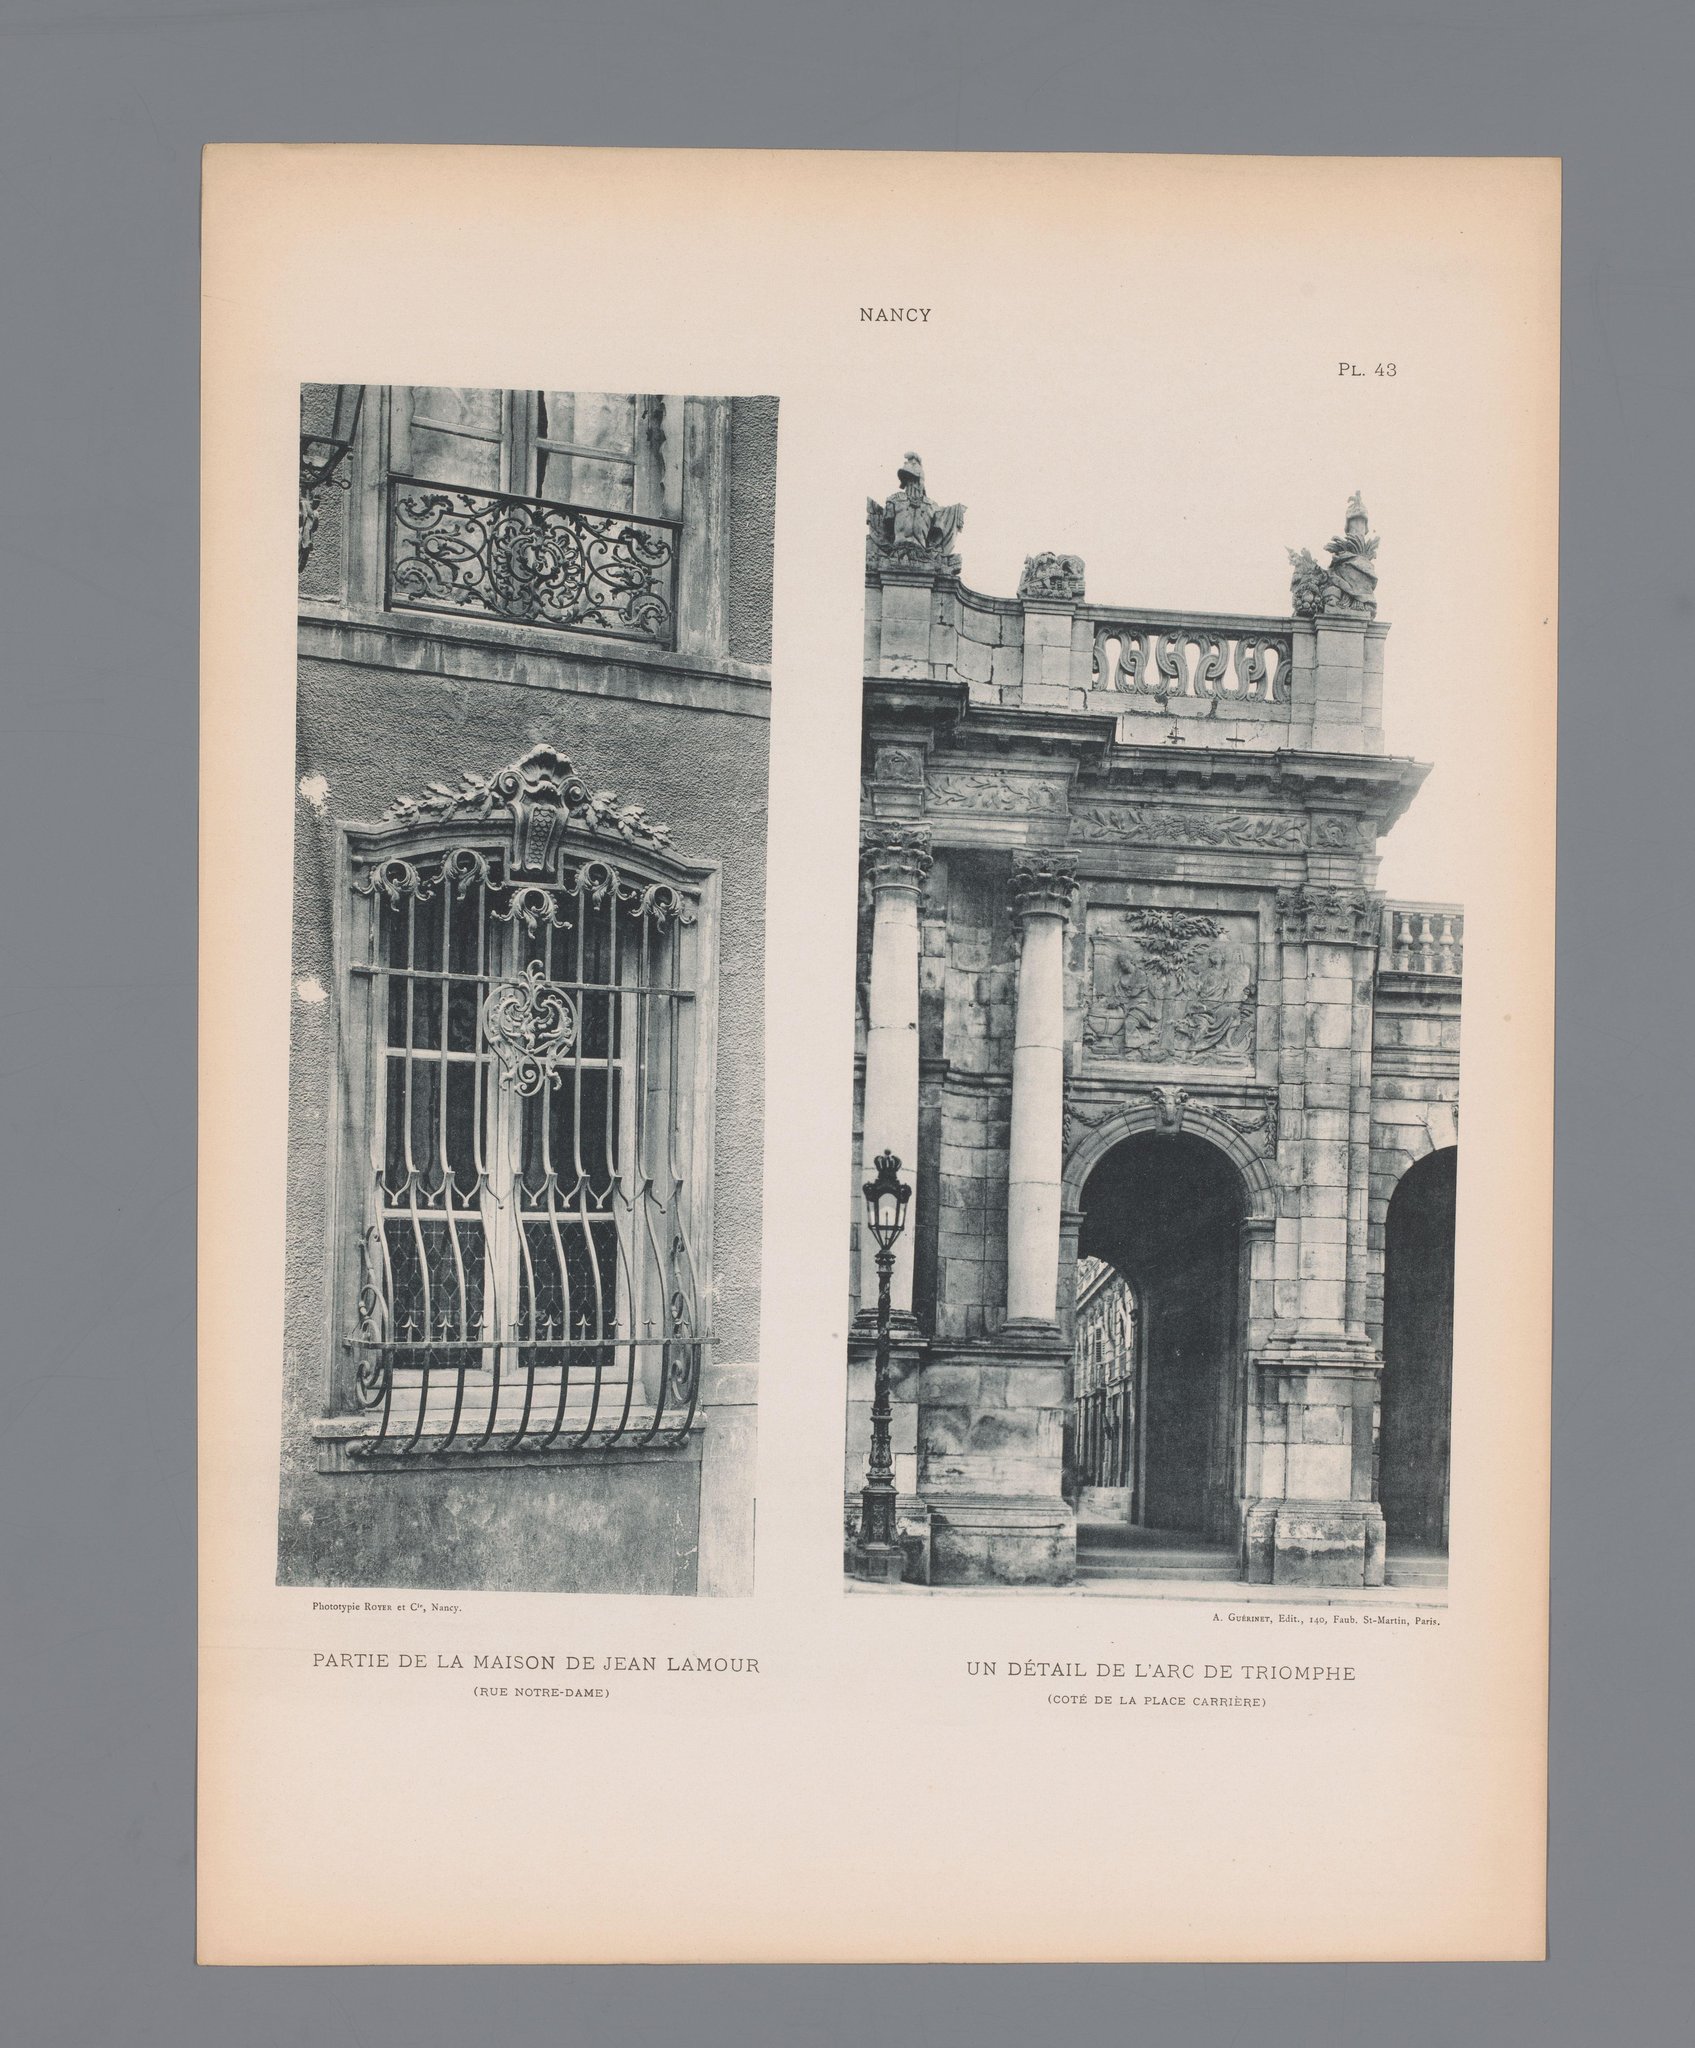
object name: photomechanical print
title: Detail van Maison de Jean Lamour en een detail van de Arc Héré te Nancy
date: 1891-1896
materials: paper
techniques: photograph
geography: paris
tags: window, triumphal arch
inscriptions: inscription: ‘Partie de la Maison de Jean Lamour/ (rue Notre-Dame)/ Un détail de l'arc de triomphe/ (coté de la place Carrière)’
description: Deze prent maakt deel uit van een omslag met 103 prenten op 101 bladen en een titelblad.